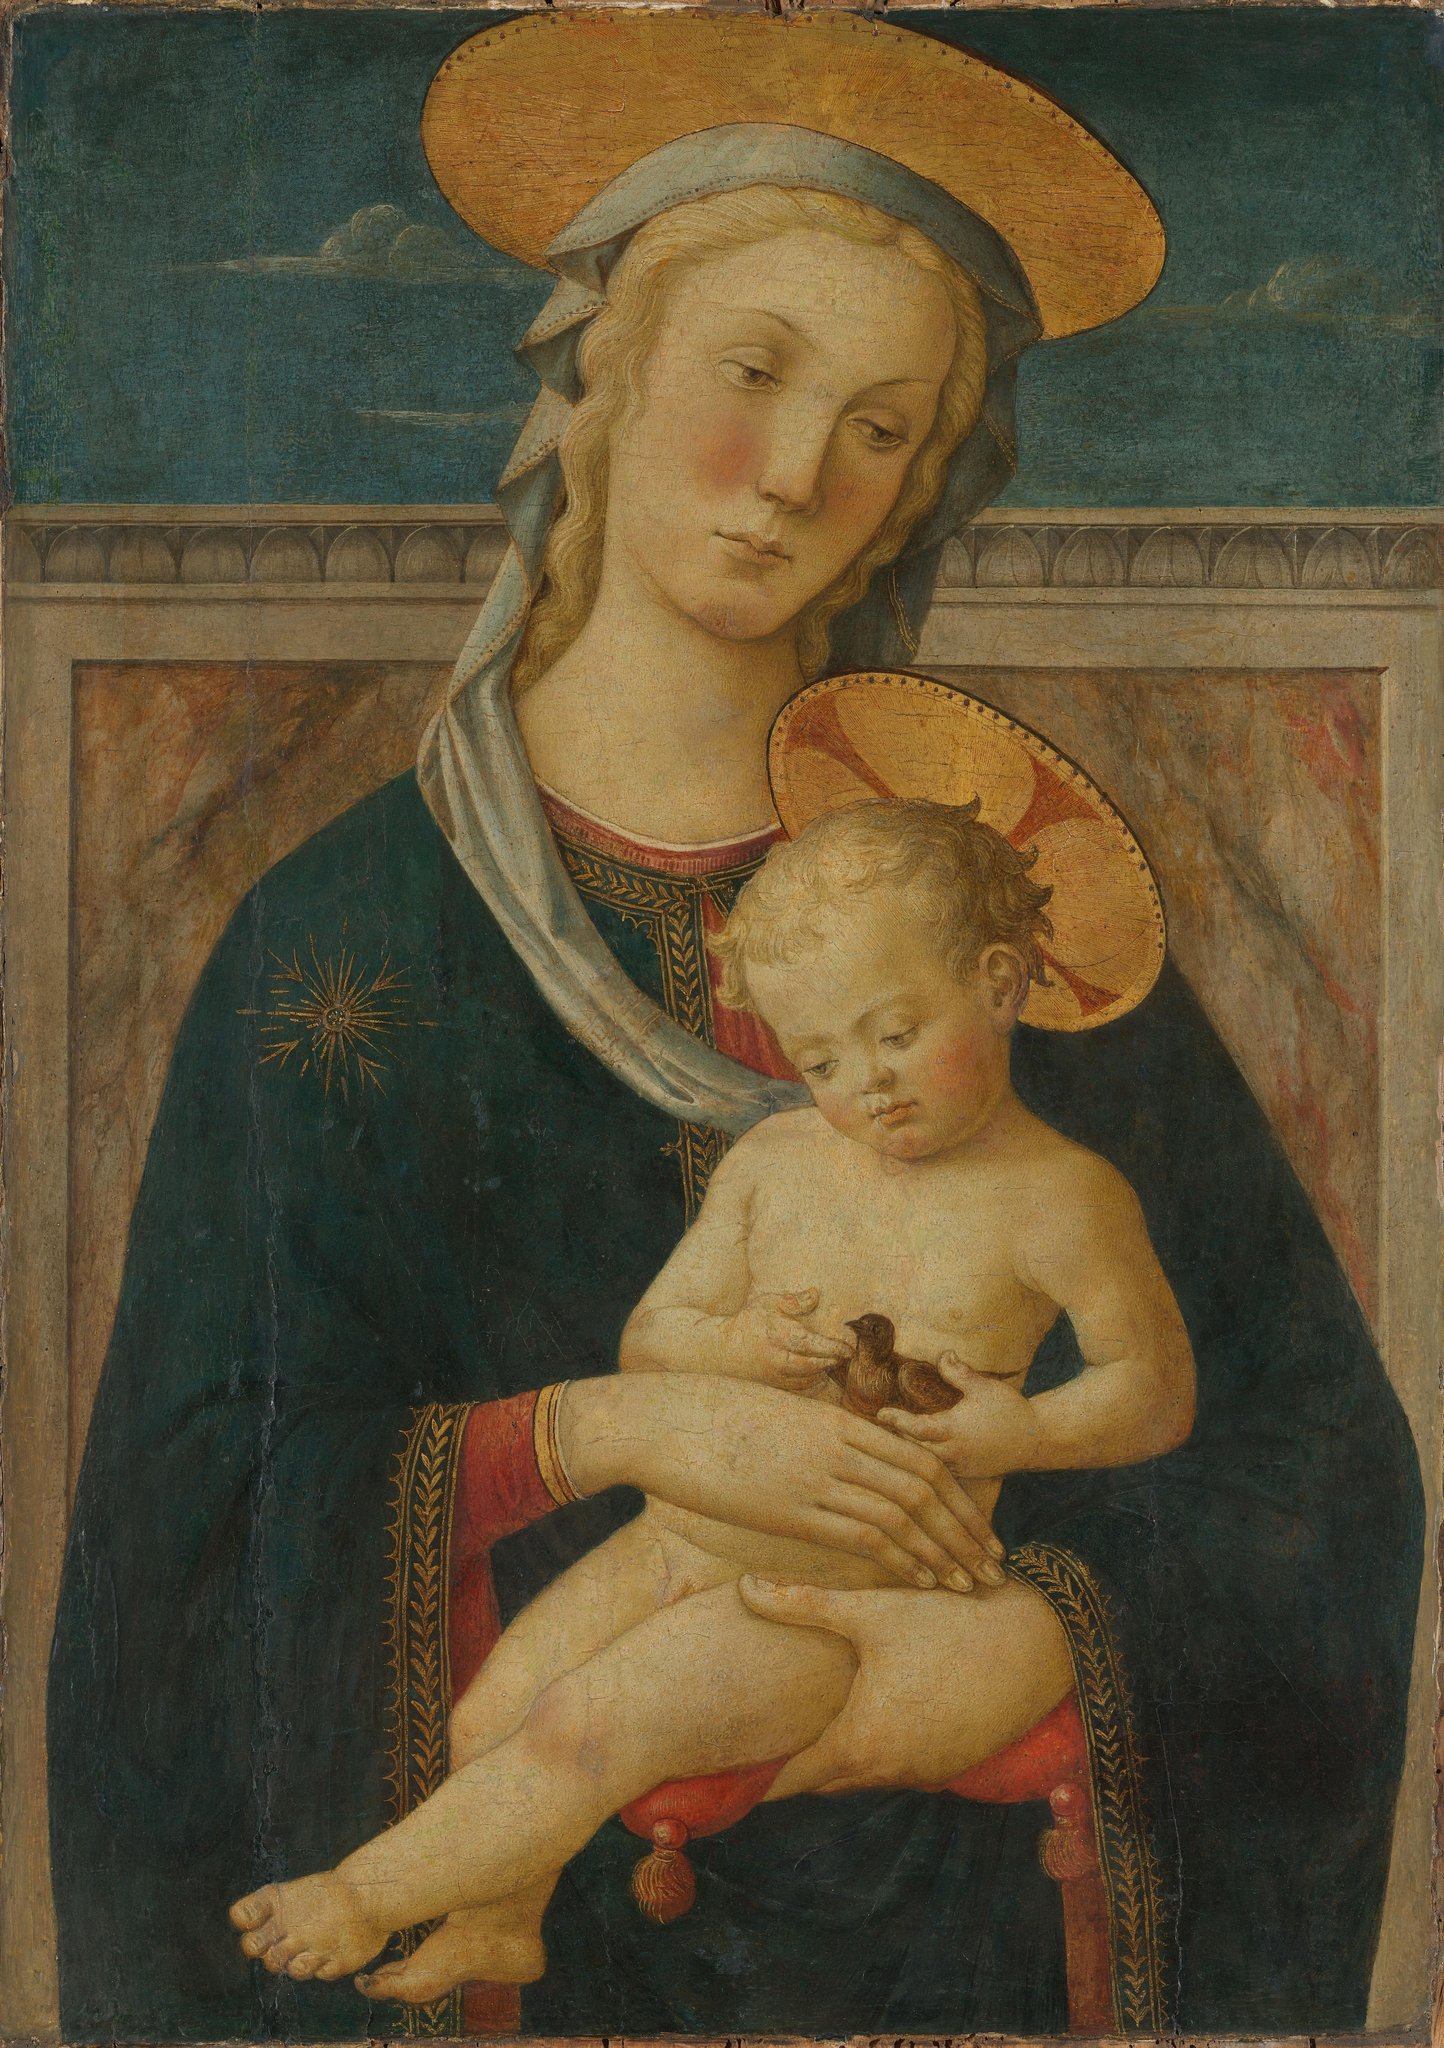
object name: painting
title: Virgin and Child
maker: meester van san miniato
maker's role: painter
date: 1460-1480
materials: panel, paint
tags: madonna: mary standing (or half-length), christ-child close to her bosom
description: Madonna met kind. Halffiguur van Maria staande voor een muur bekleed met marmer met het Christuskind in de armen voor de borst. Het kind speelt met een vogeltje.